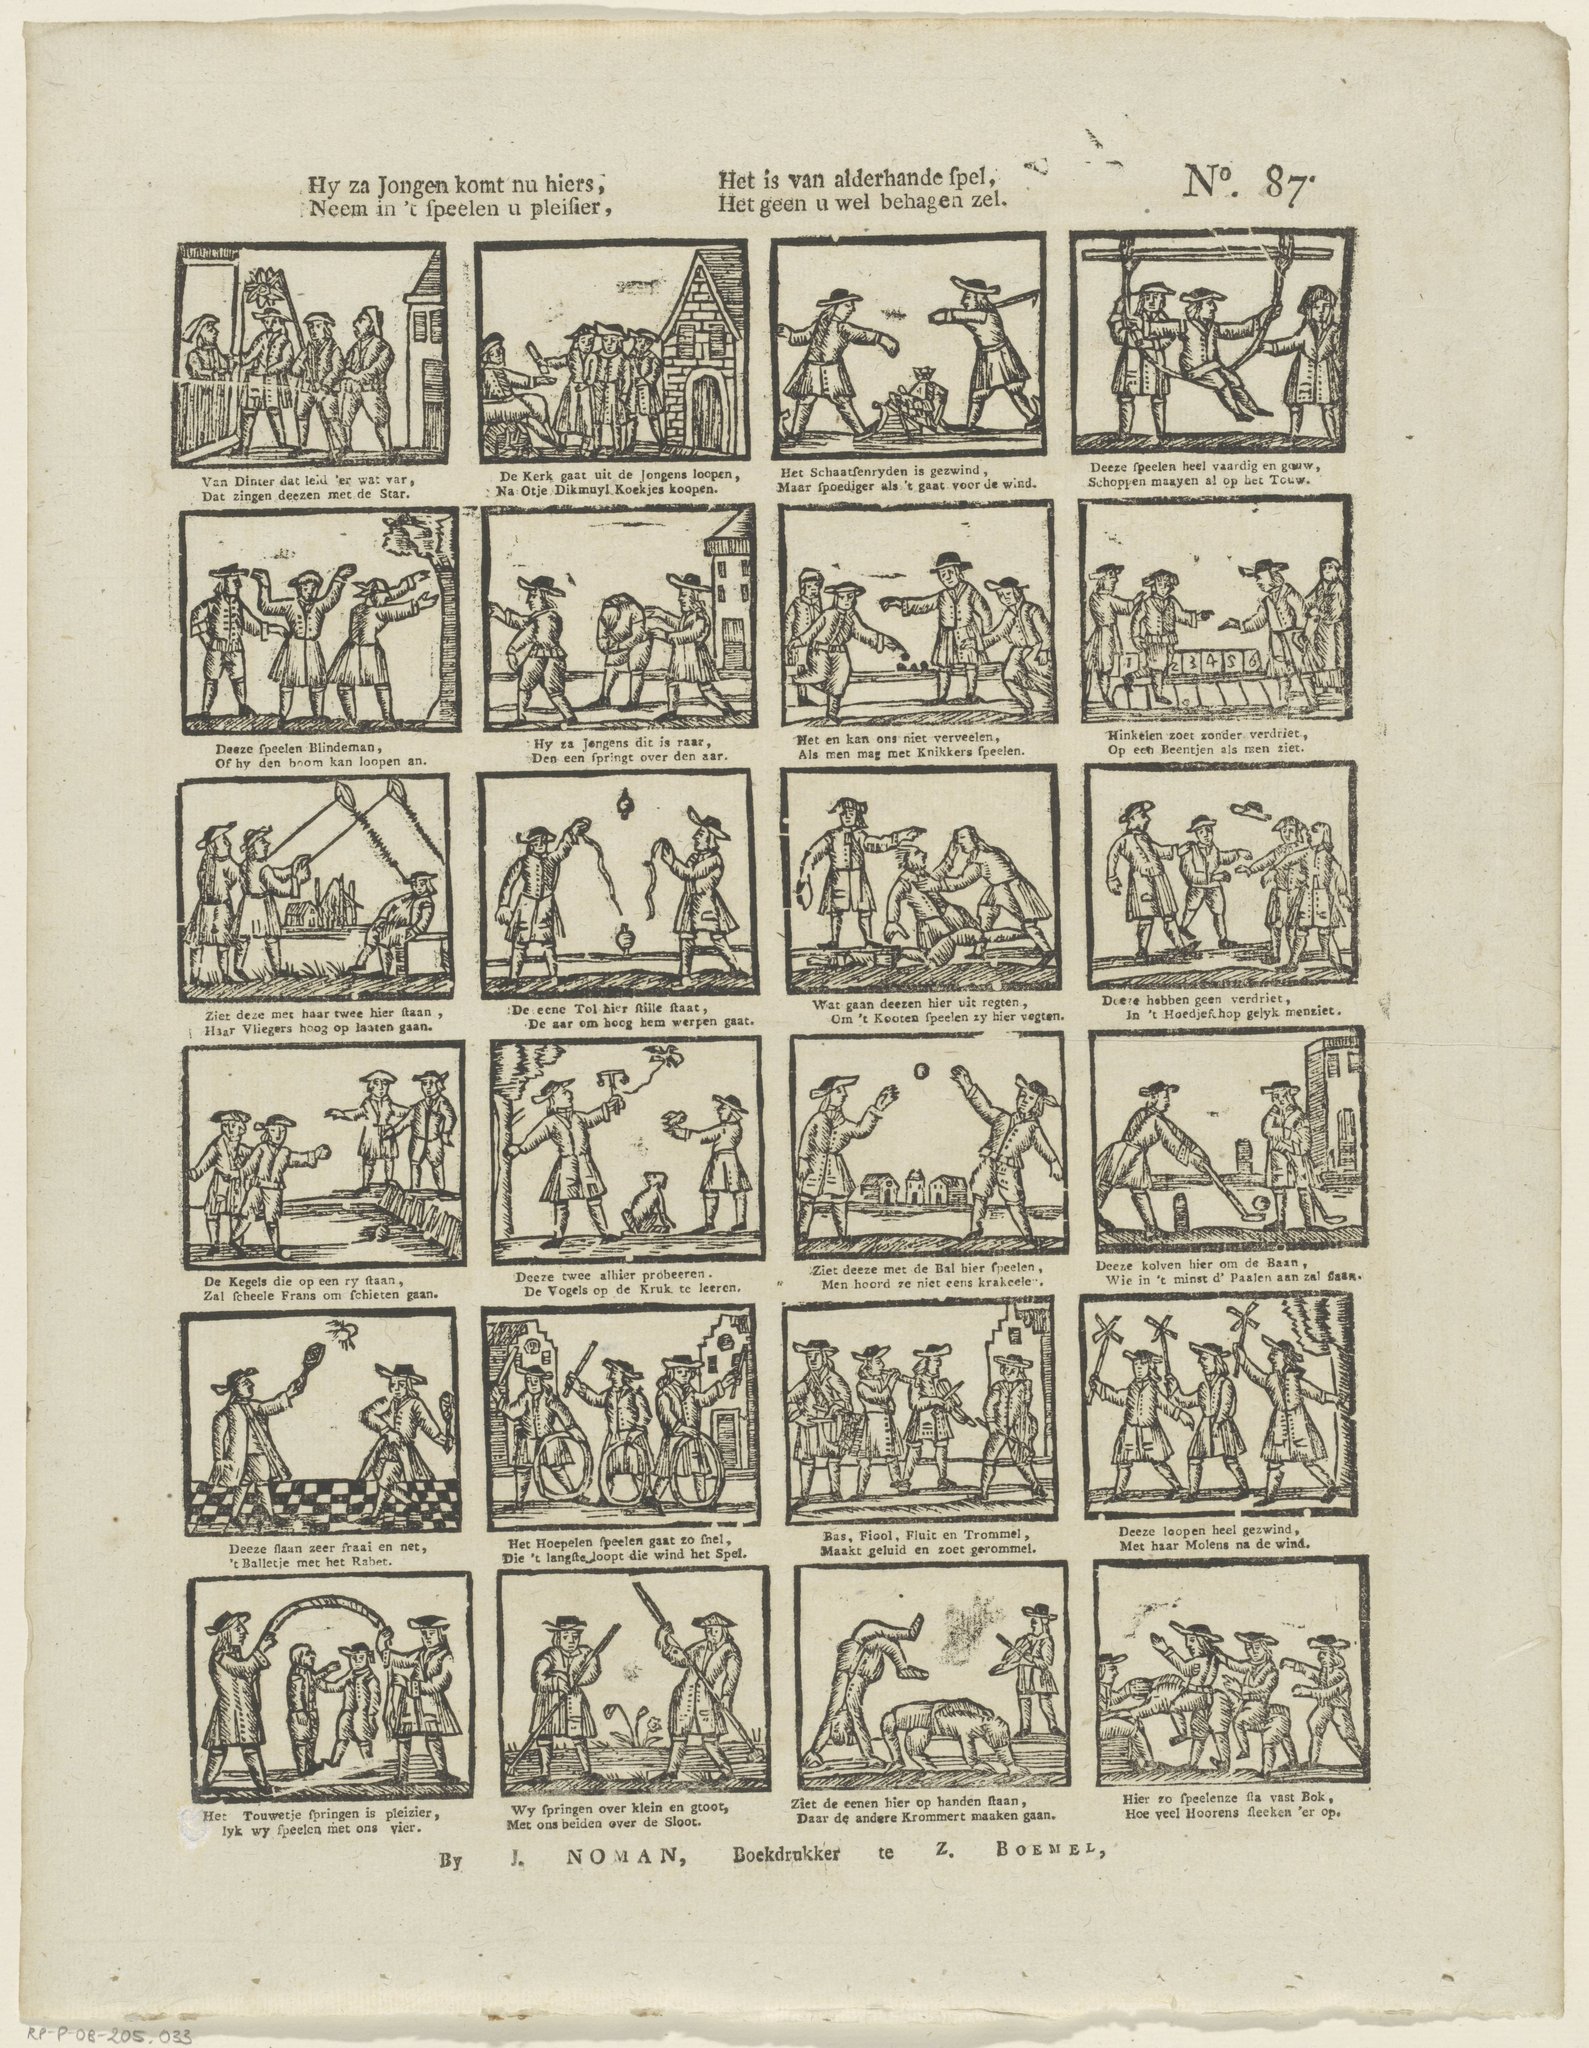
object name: popular print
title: Hy za jongen komt nu hiers, / Neem in 't speelen u pleisier, / Het is van alderhande spel, / Het geen u wel behagen zel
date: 1806-1830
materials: paper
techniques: letterpress printing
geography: netherlands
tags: children's games and plays, swinging (children's game), (flying a) kite, games using special objects (marbles, top, hoop, etc.), jumping-rope games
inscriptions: collector's mark: Lugt 2760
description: Blad met 24 voorstellingen van kinderspelen, zoals schommelen, vliegeren, hoepelen en touwtjespringen. Onder elke afbeelding een tweeregelig vers. Genummerd rechtsboven: No. 87.